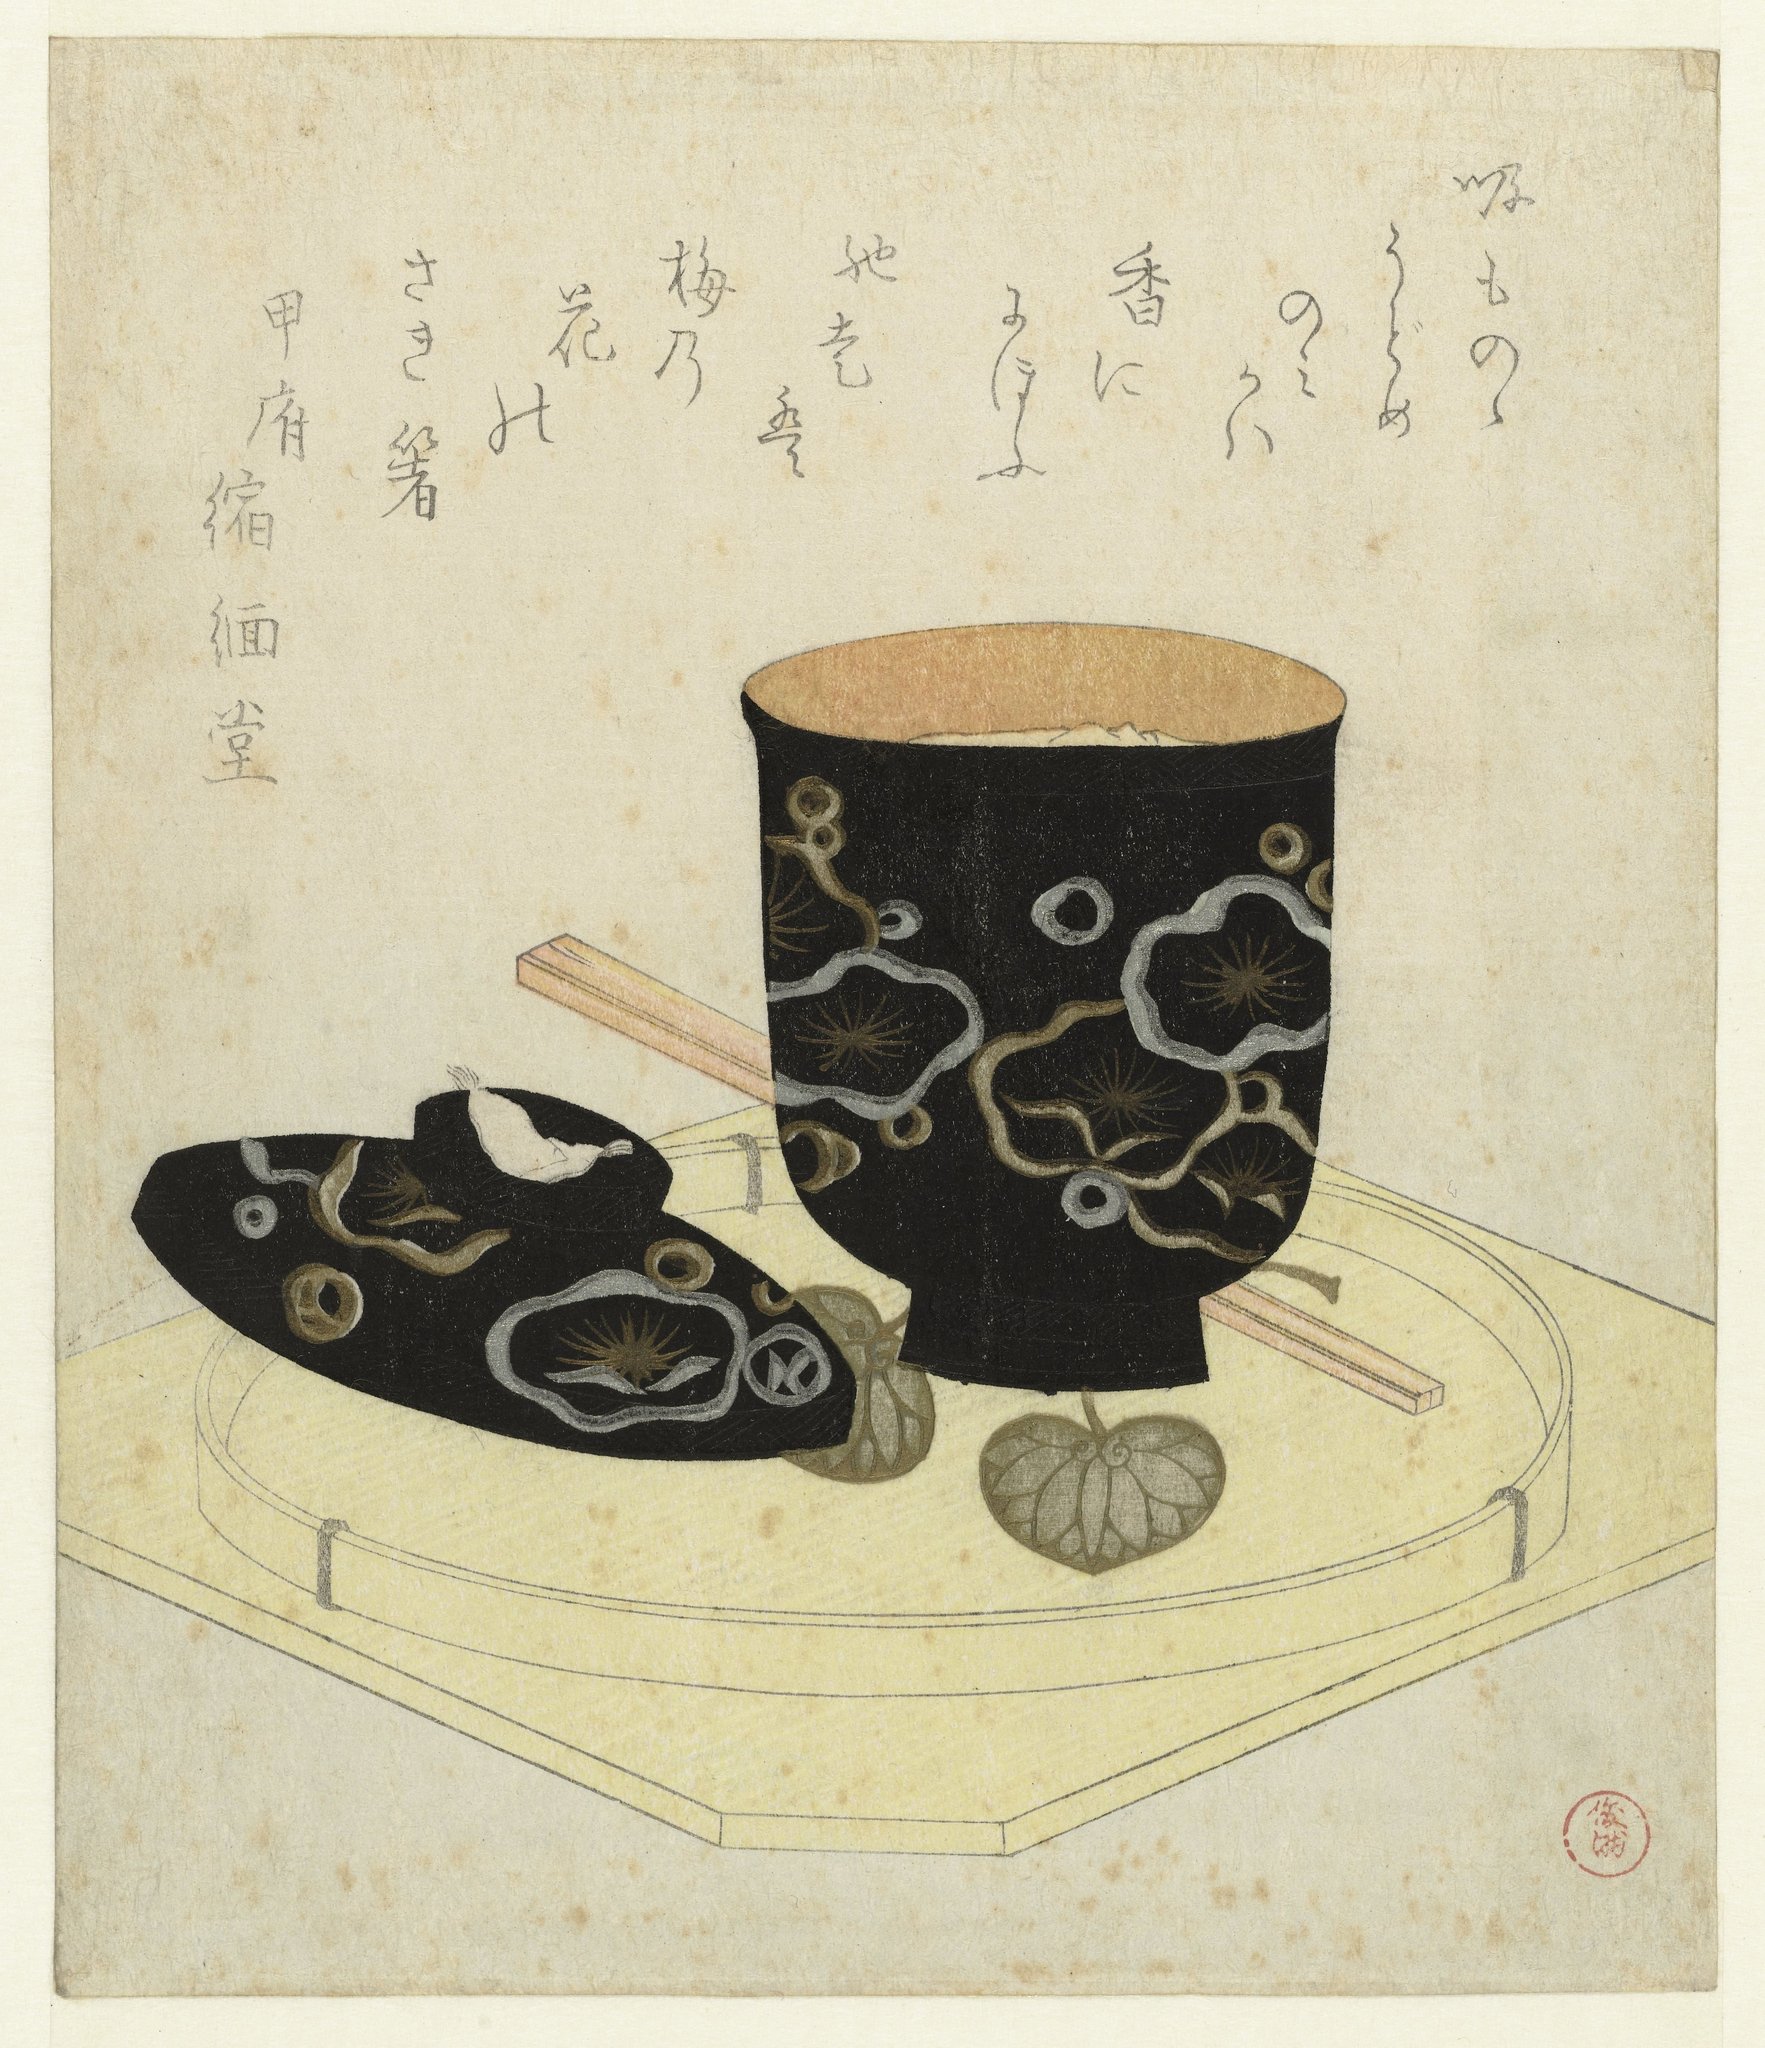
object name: surimono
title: A Lacquer Bowl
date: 1815-1820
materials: paper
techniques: blind stamped, woodcut, polish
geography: japan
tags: bowl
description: Een surimono is een luxe uitgevoerde prent waarop beeld met één of meerdere gedichten gecombineerd is. Bij het drukken van een surimono werd vaak gebruik gemaakt van dikker papier, blinddruk en metaal pigmenten, zoals koper- en zilverpoeder. De prenten werden vaak in opdracht van dichters gemaakt en als exclusief geschenk aan vrienden en relaties gegeven.